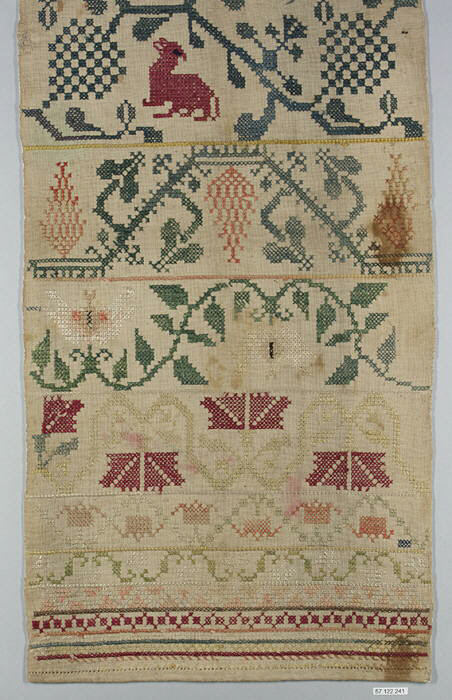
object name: sampler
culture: mexican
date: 1801-1900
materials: cotton, silk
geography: mexico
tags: animals,leaves